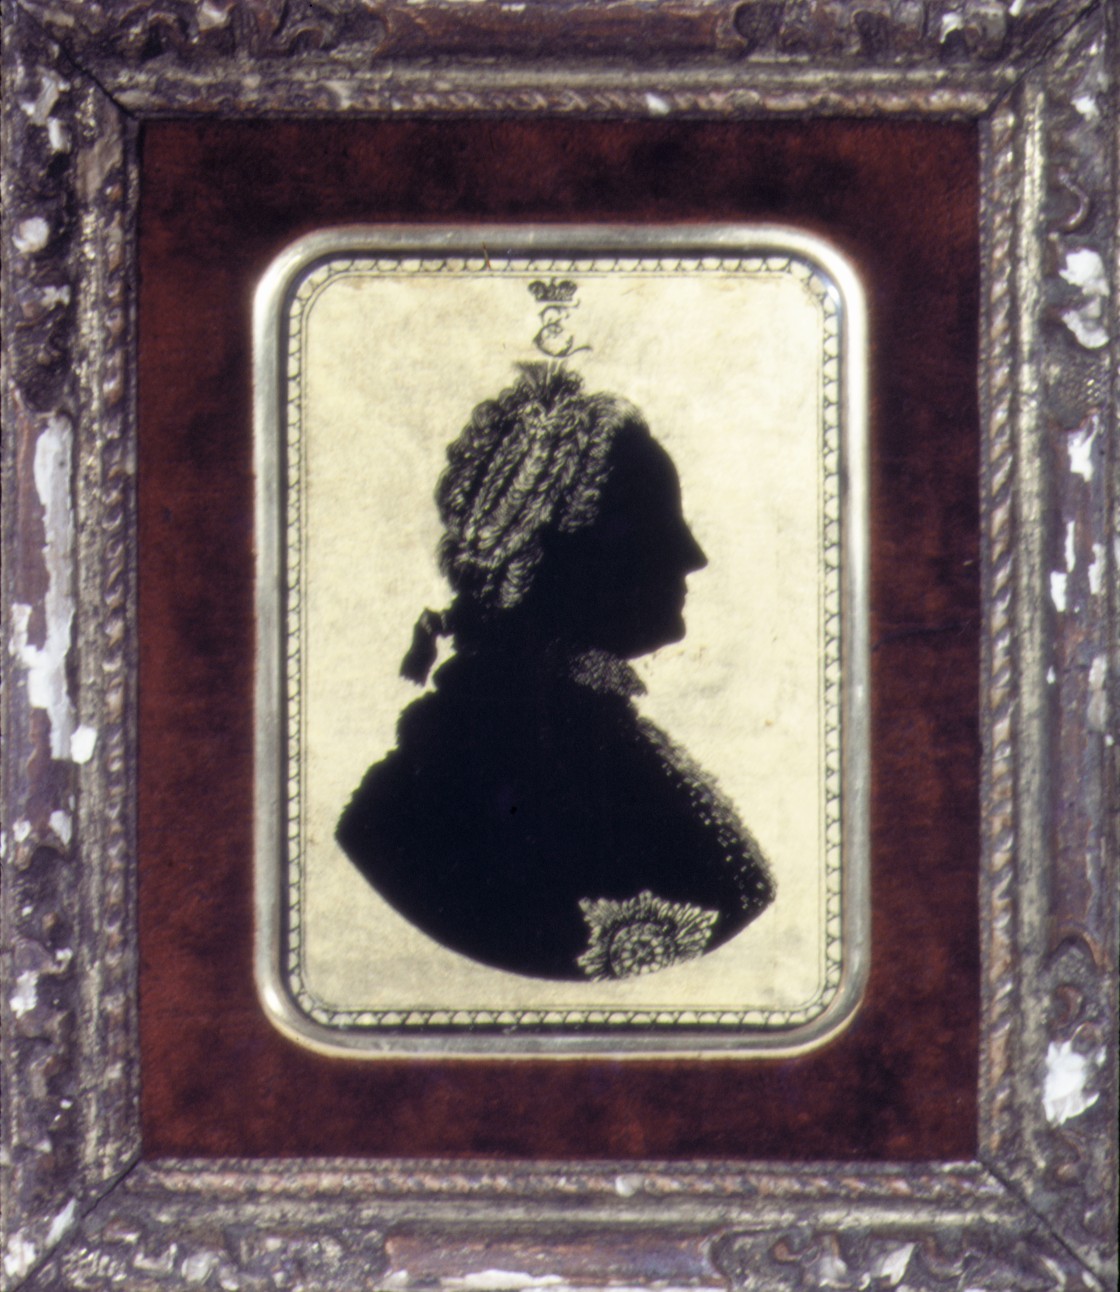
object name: panel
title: Catherine II (1729–1796), Empress of Russia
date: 1751-1800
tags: profiles,women